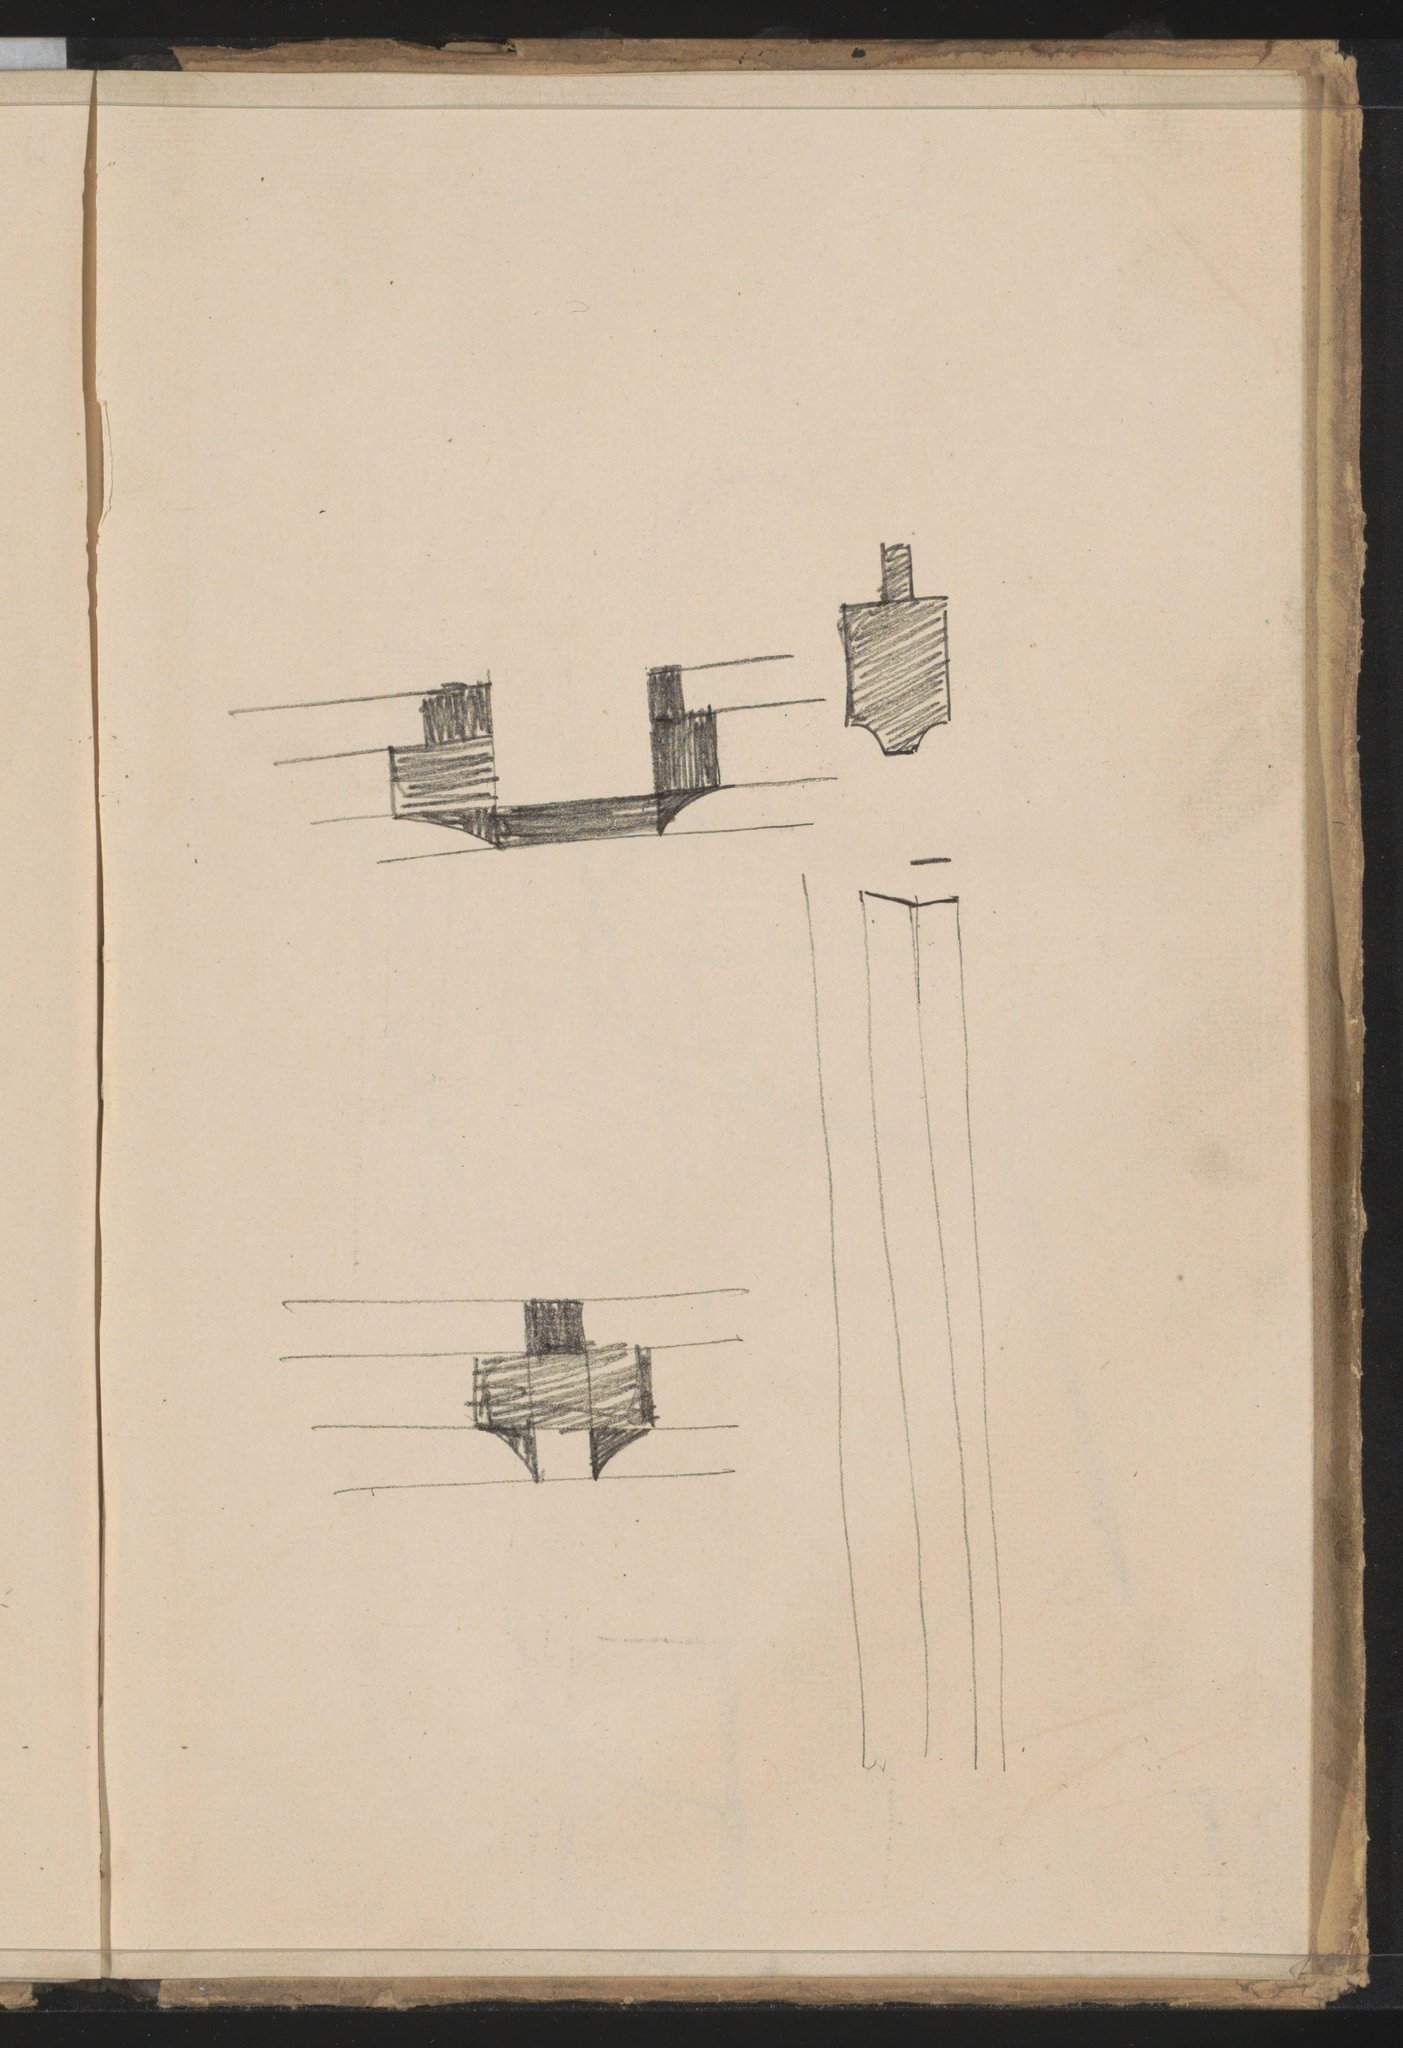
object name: sketchbook leaf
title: Architectuurstudies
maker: carel adolph lion cachet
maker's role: draughtsman, print maker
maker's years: 1864-1945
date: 1890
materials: paper, pencil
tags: architecture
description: Blad 35 recto uit een schetsboek met 38 bladen.